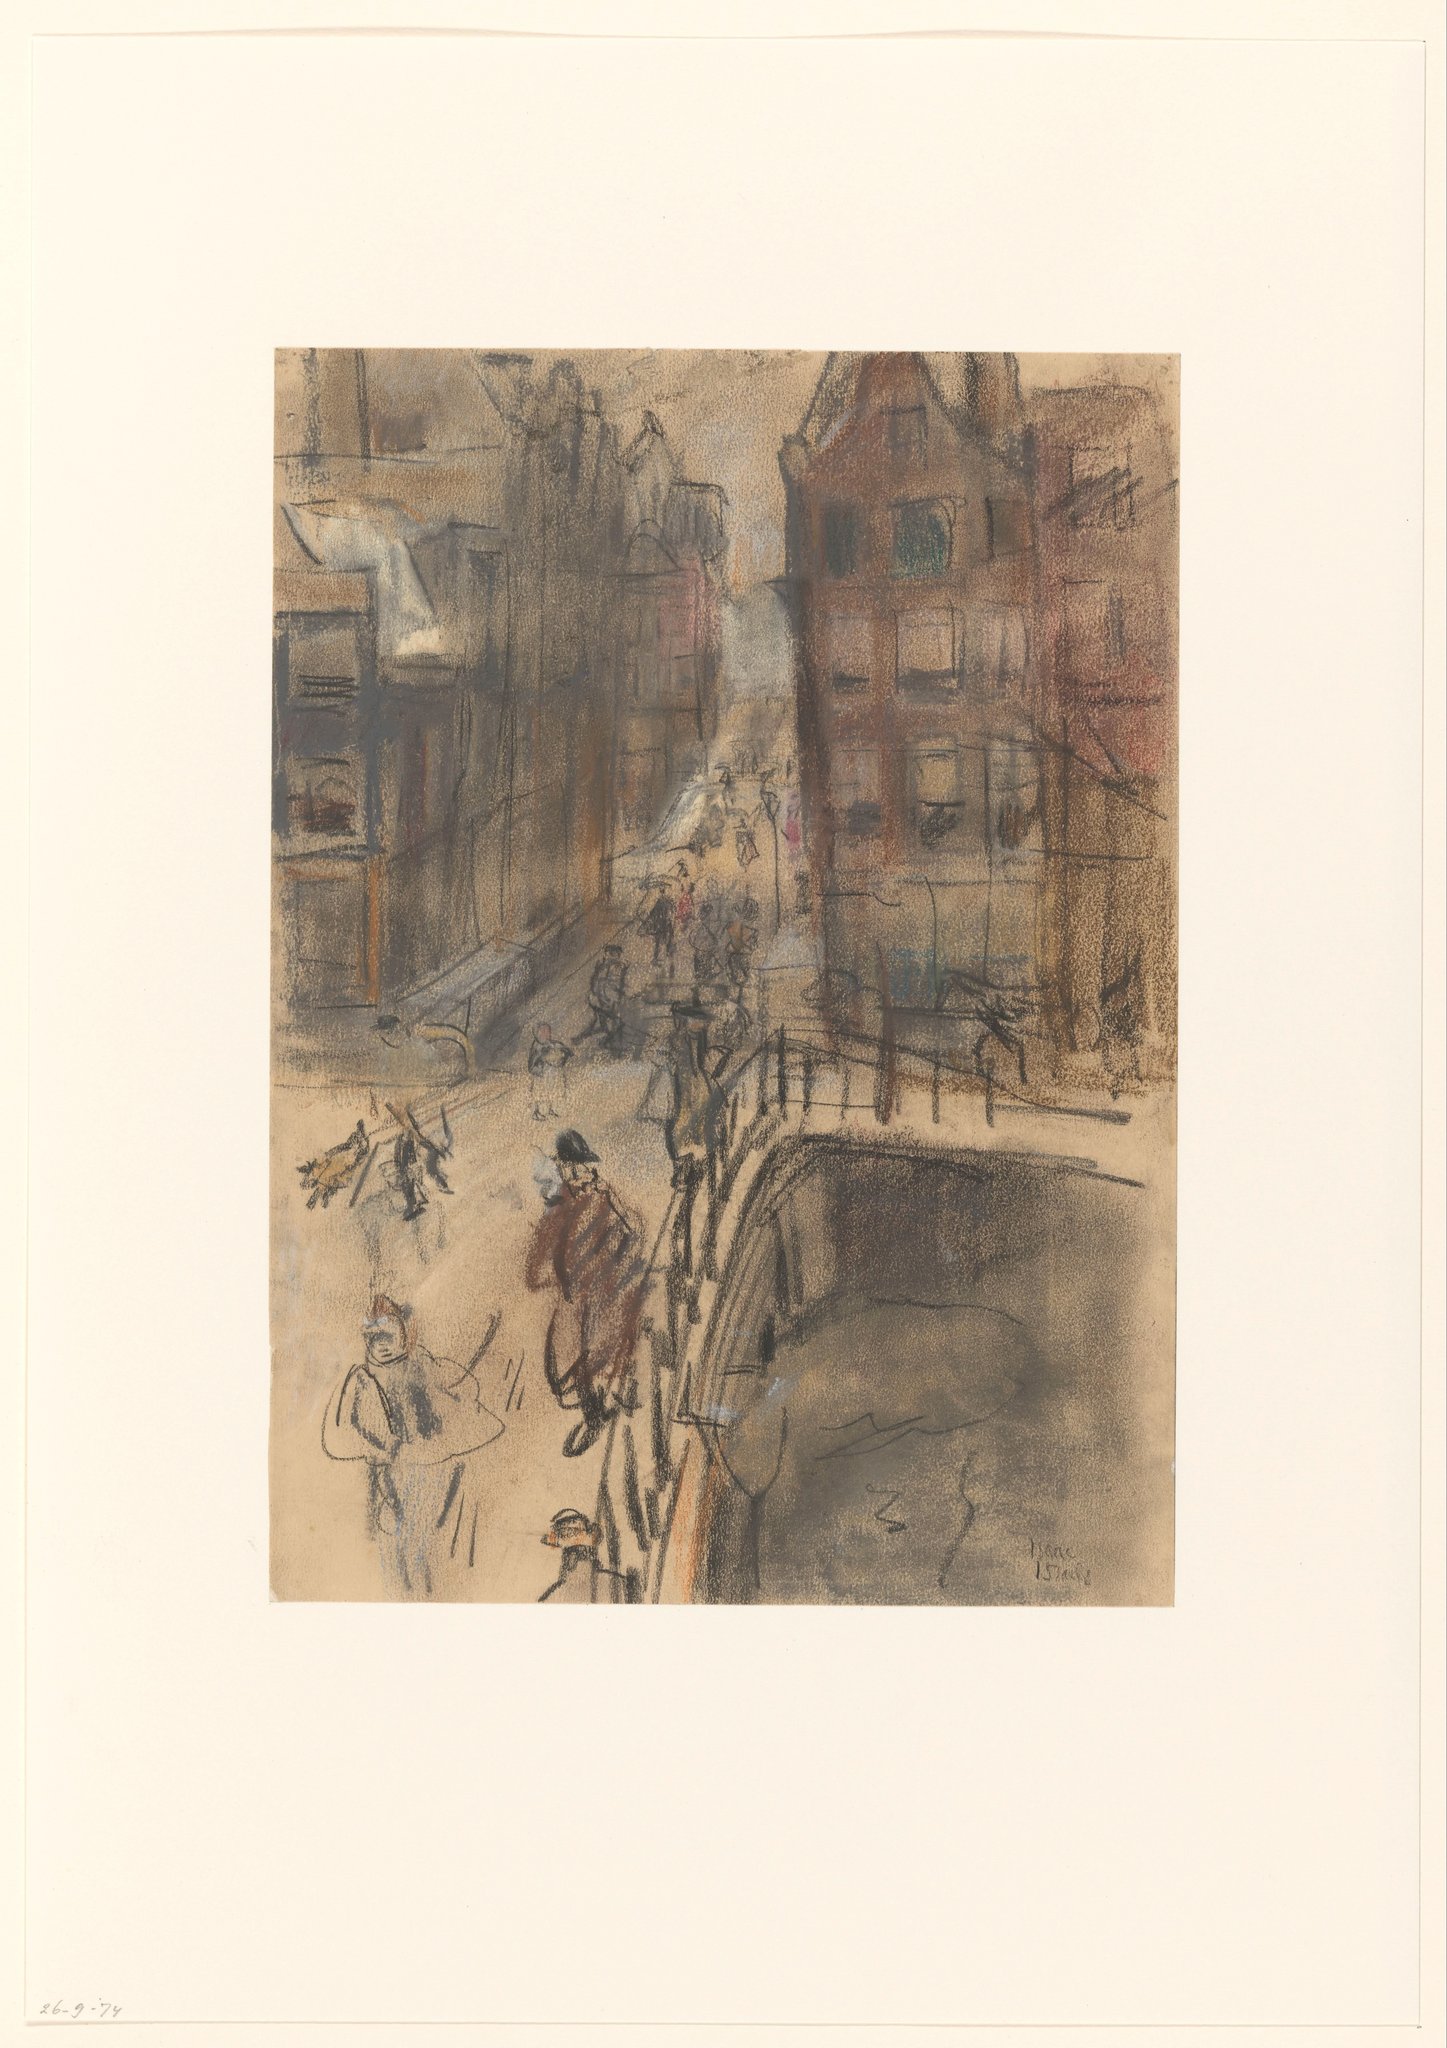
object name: drawing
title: Amsterdams stadsgezicht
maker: isaac israels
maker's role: draughtsman, painter, print maker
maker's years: 1865-1934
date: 1894-1895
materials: paper, pastel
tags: street, amsterdam